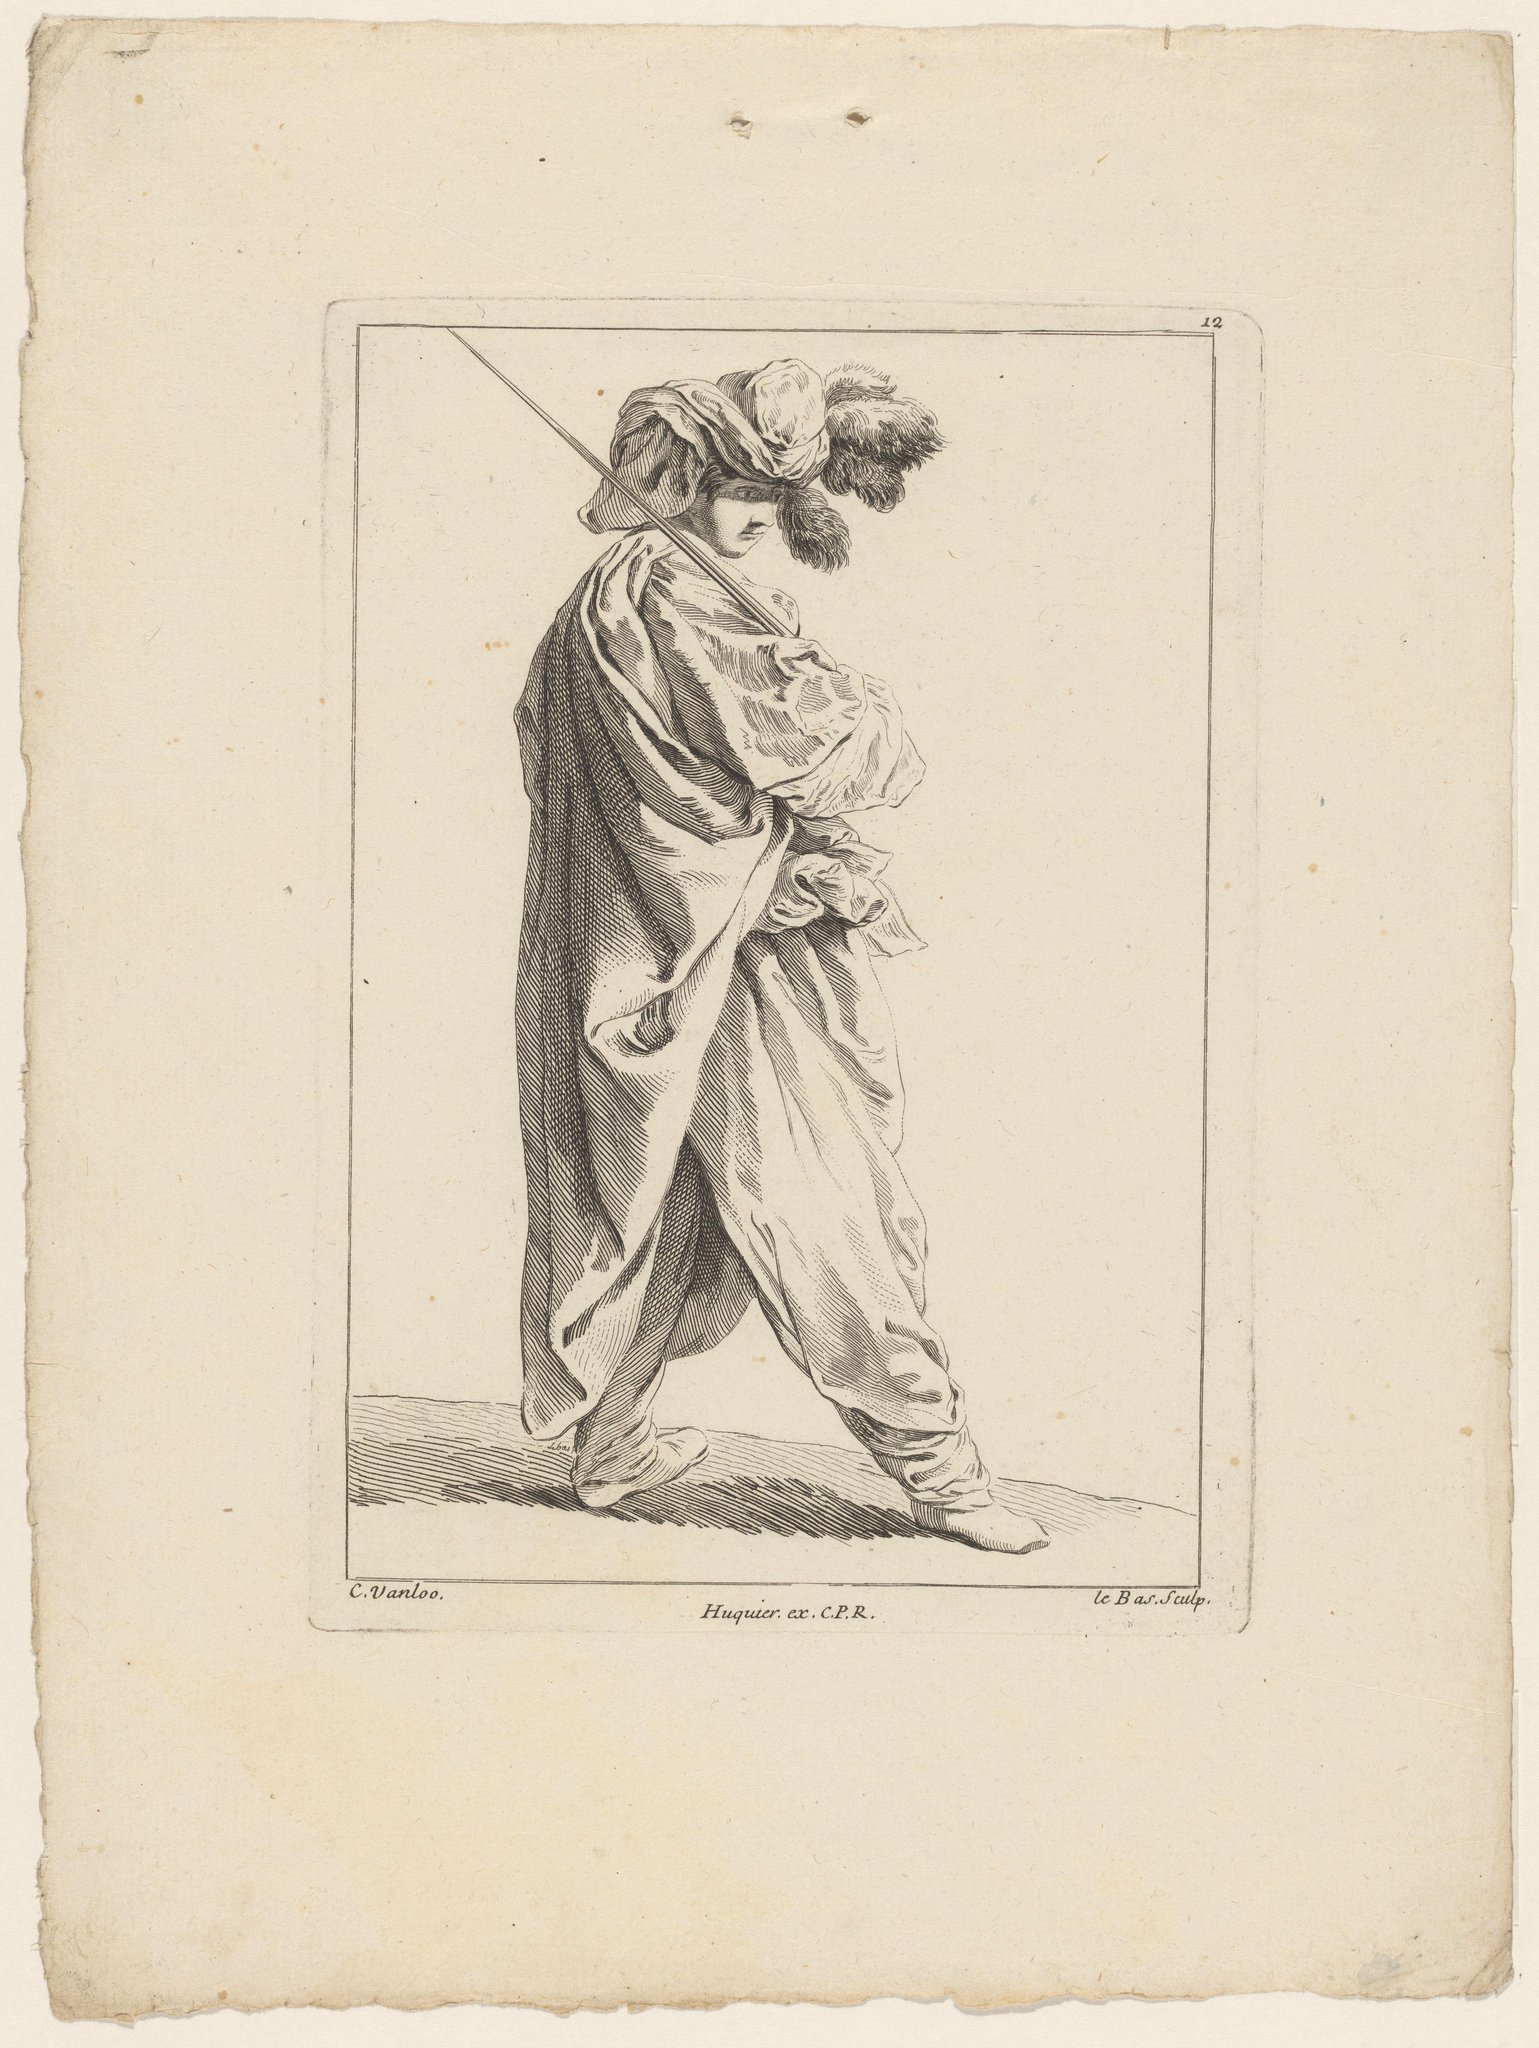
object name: print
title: Verzameling van verschillende gedramatiseerde poses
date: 1732-1740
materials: paper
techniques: etching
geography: rome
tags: passions, emotions, affections, asiatic races and peoples (+ costume), head-gear: turban, characters (human types), actor (on the stage)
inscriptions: collector's mark: Lugt 2228, collector's mark: Lugt 2760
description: Staande man met tulband met veren, degen over de schouder, naar rechts gekeerd. Rechtsboven genummerd: 12. Onderdeel van een serie van twaalf prenten met figuren in gedramatiseerde poses, veelal gekleed in ‘Oosterse’ fantasiekostuums, naar tekeningen van Carle van Loo, gemaakt tijdens zijn verblijf in Rome (1728-1732).